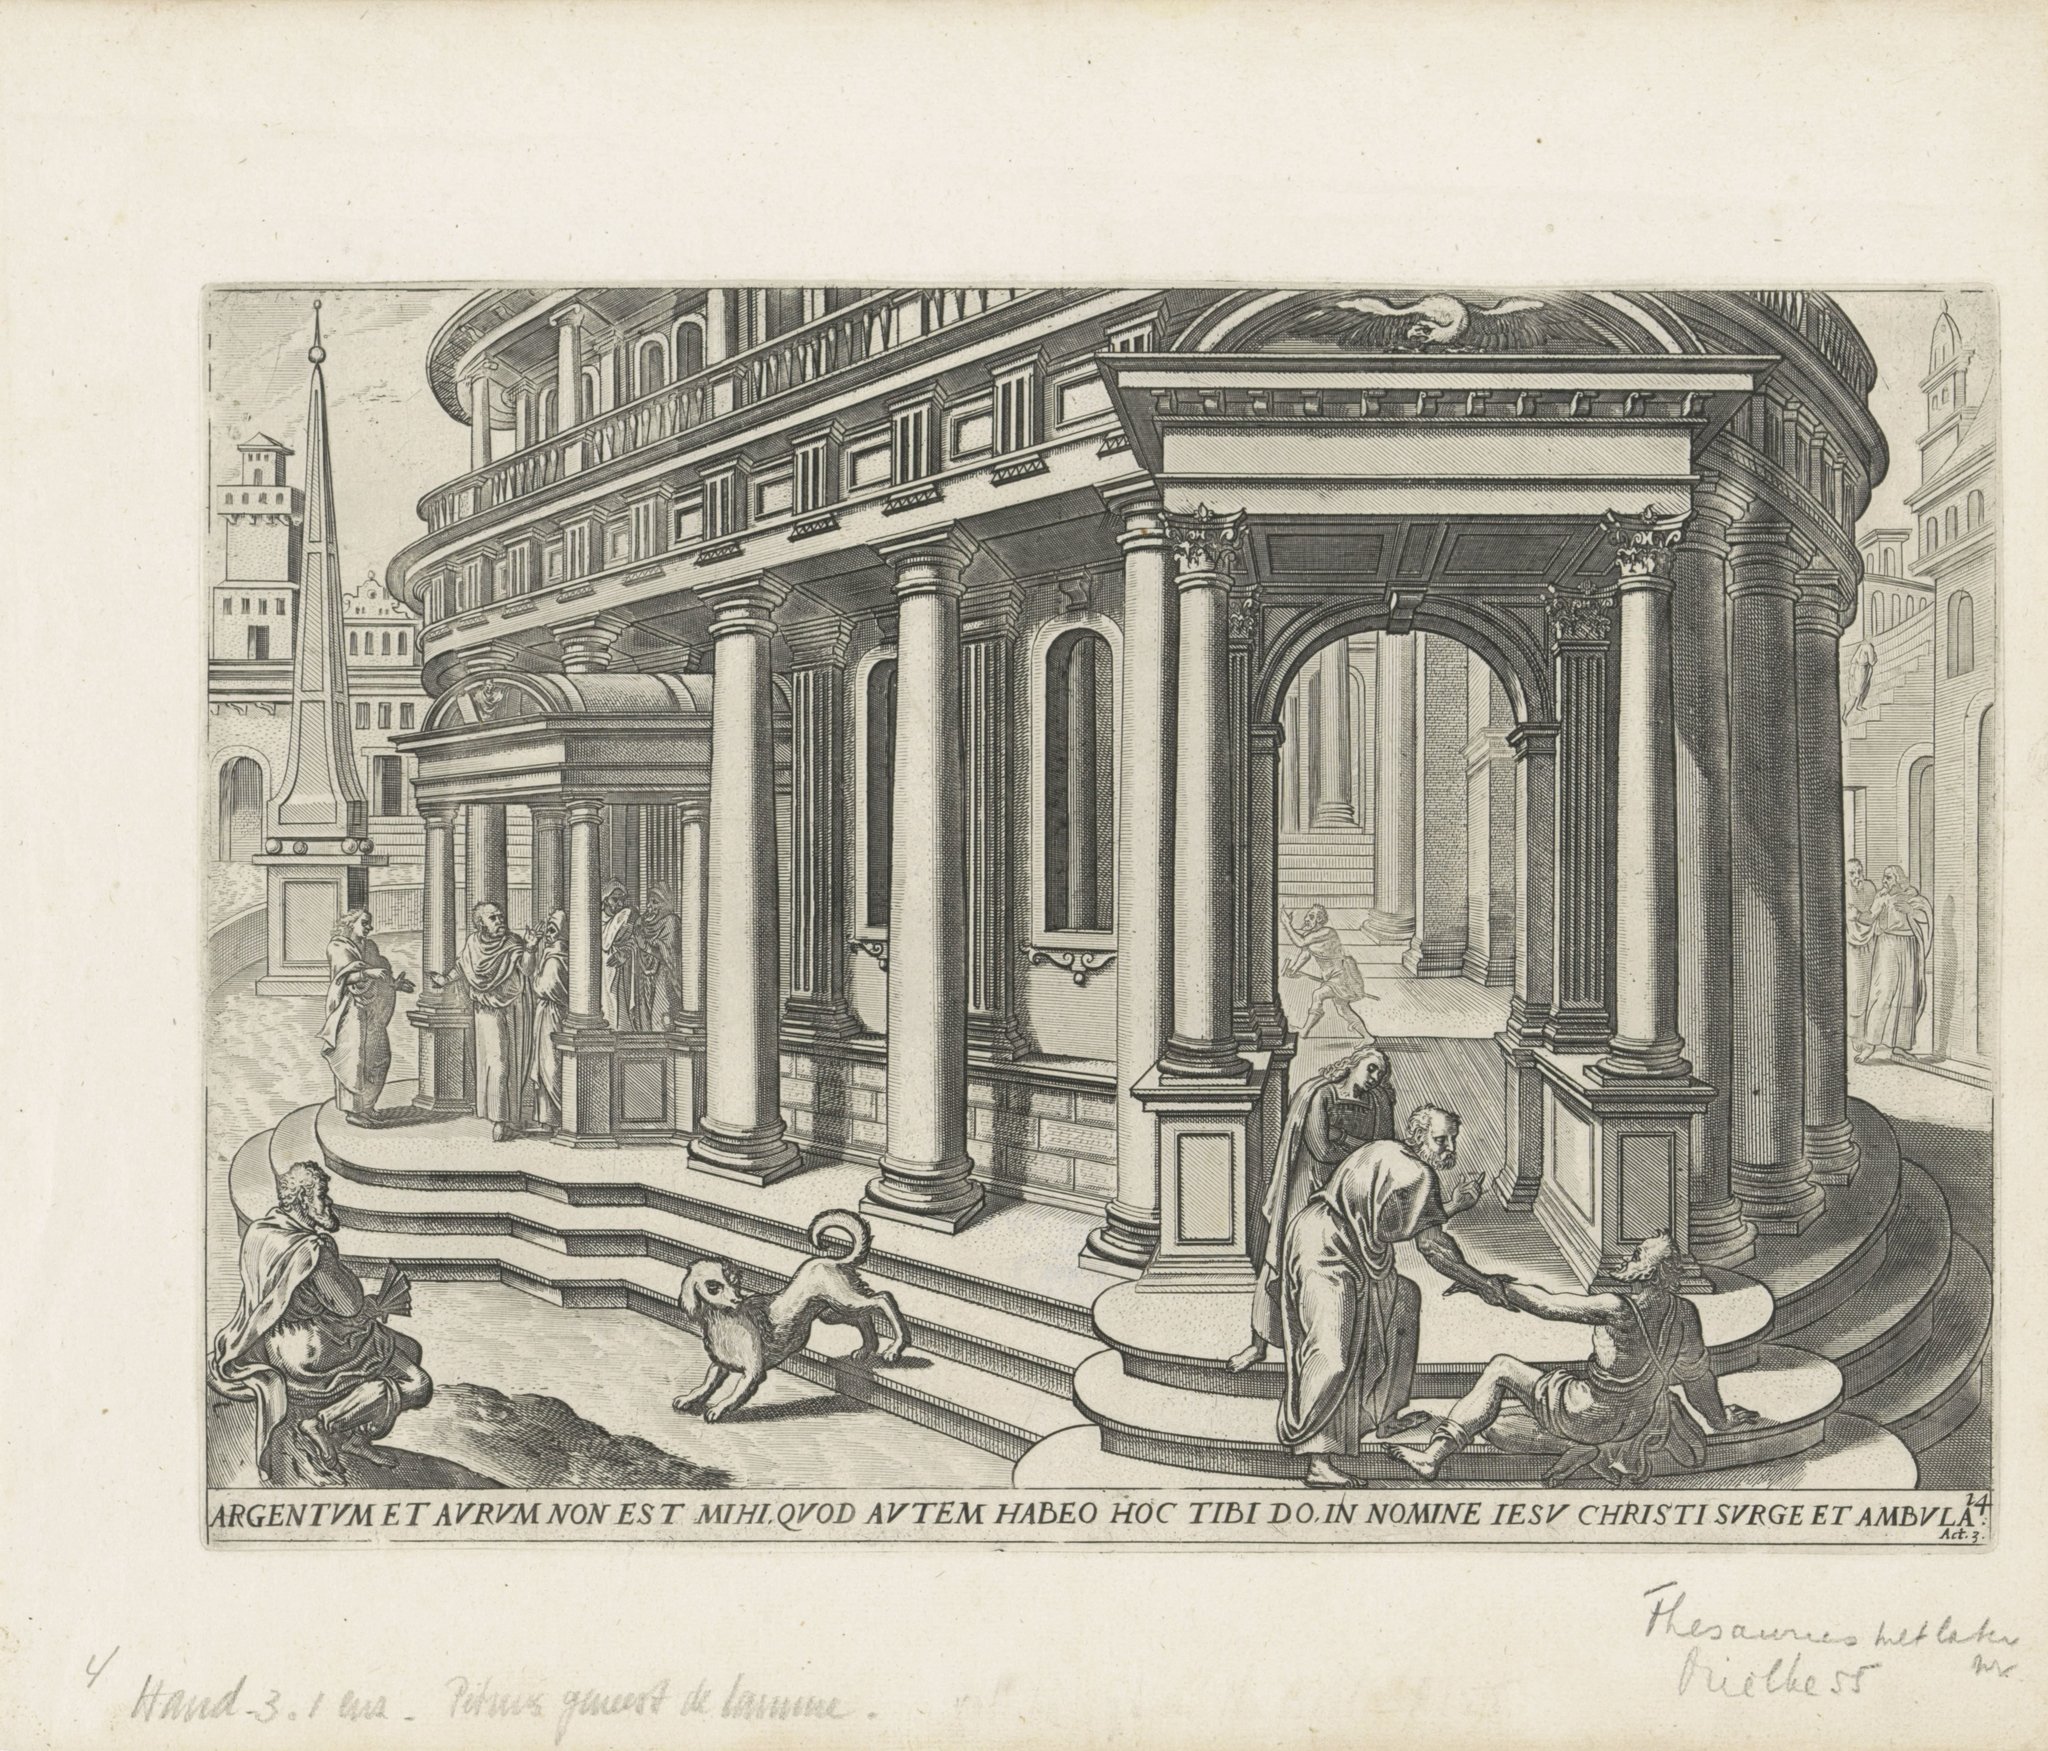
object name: print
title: Peter and John heal a paralyzed man at the temple gate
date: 1585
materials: paper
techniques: engraving, etching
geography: amsterdam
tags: healing of a lame beggar at the beautiful gate of the temple by peter and john (acts 3 - 4:31), peter, john and the healed man enter the temple, where peter delivers a sermon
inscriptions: collector's mark: Lugt 2228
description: Bij de tempelpoort vraagt een bedelaar Petrus en Johannes om een aalmoes. Petrus heeft geen geld, maar geneest hem in de naam van Christus en helpt de man overeind. Op de achtergrond in de tempel danst en springt de man na zijn genezing. In de poort links geven Johannes en Petrus uitleg over de genezing aan enkele mensen. Onder de voorstelling een verwijzing in het Latijn naar de Bijbeltekst in Hand. 3.